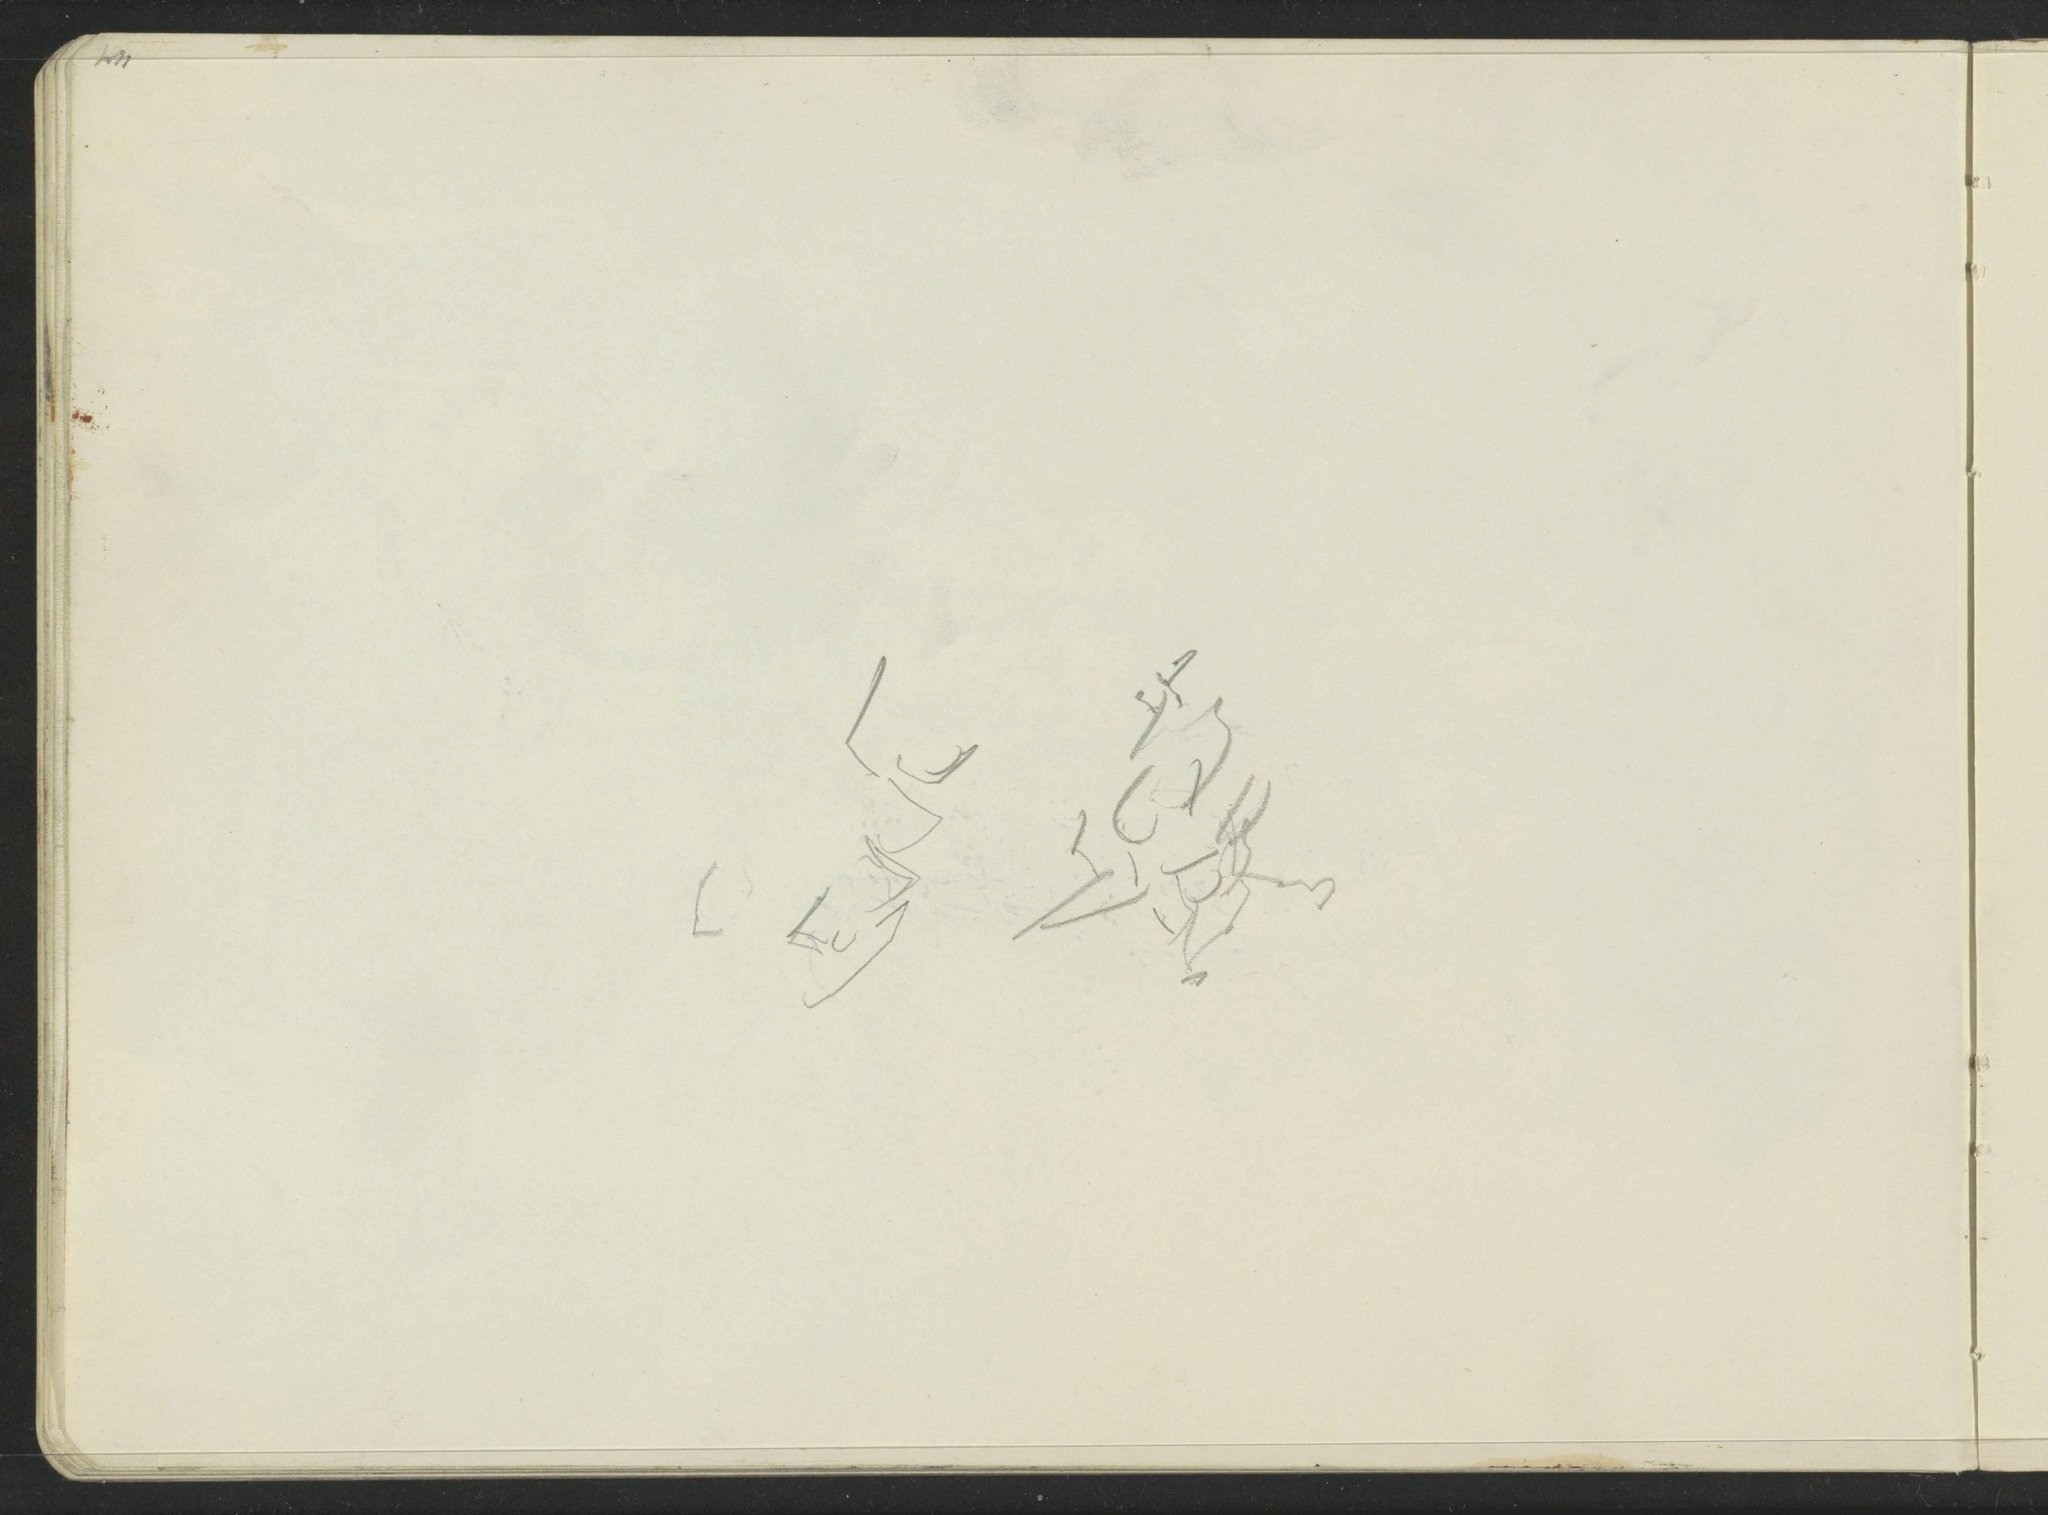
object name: sketchbook leaf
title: Twee figuurstudies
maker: isaac israels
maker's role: draughtsman, painter, print maker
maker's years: 1865-1934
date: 1915-1934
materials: paper, pencil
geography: the hague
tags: postures of the human figure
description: Blad 27 verso uit schetsboek XVIII met 35 bladen.